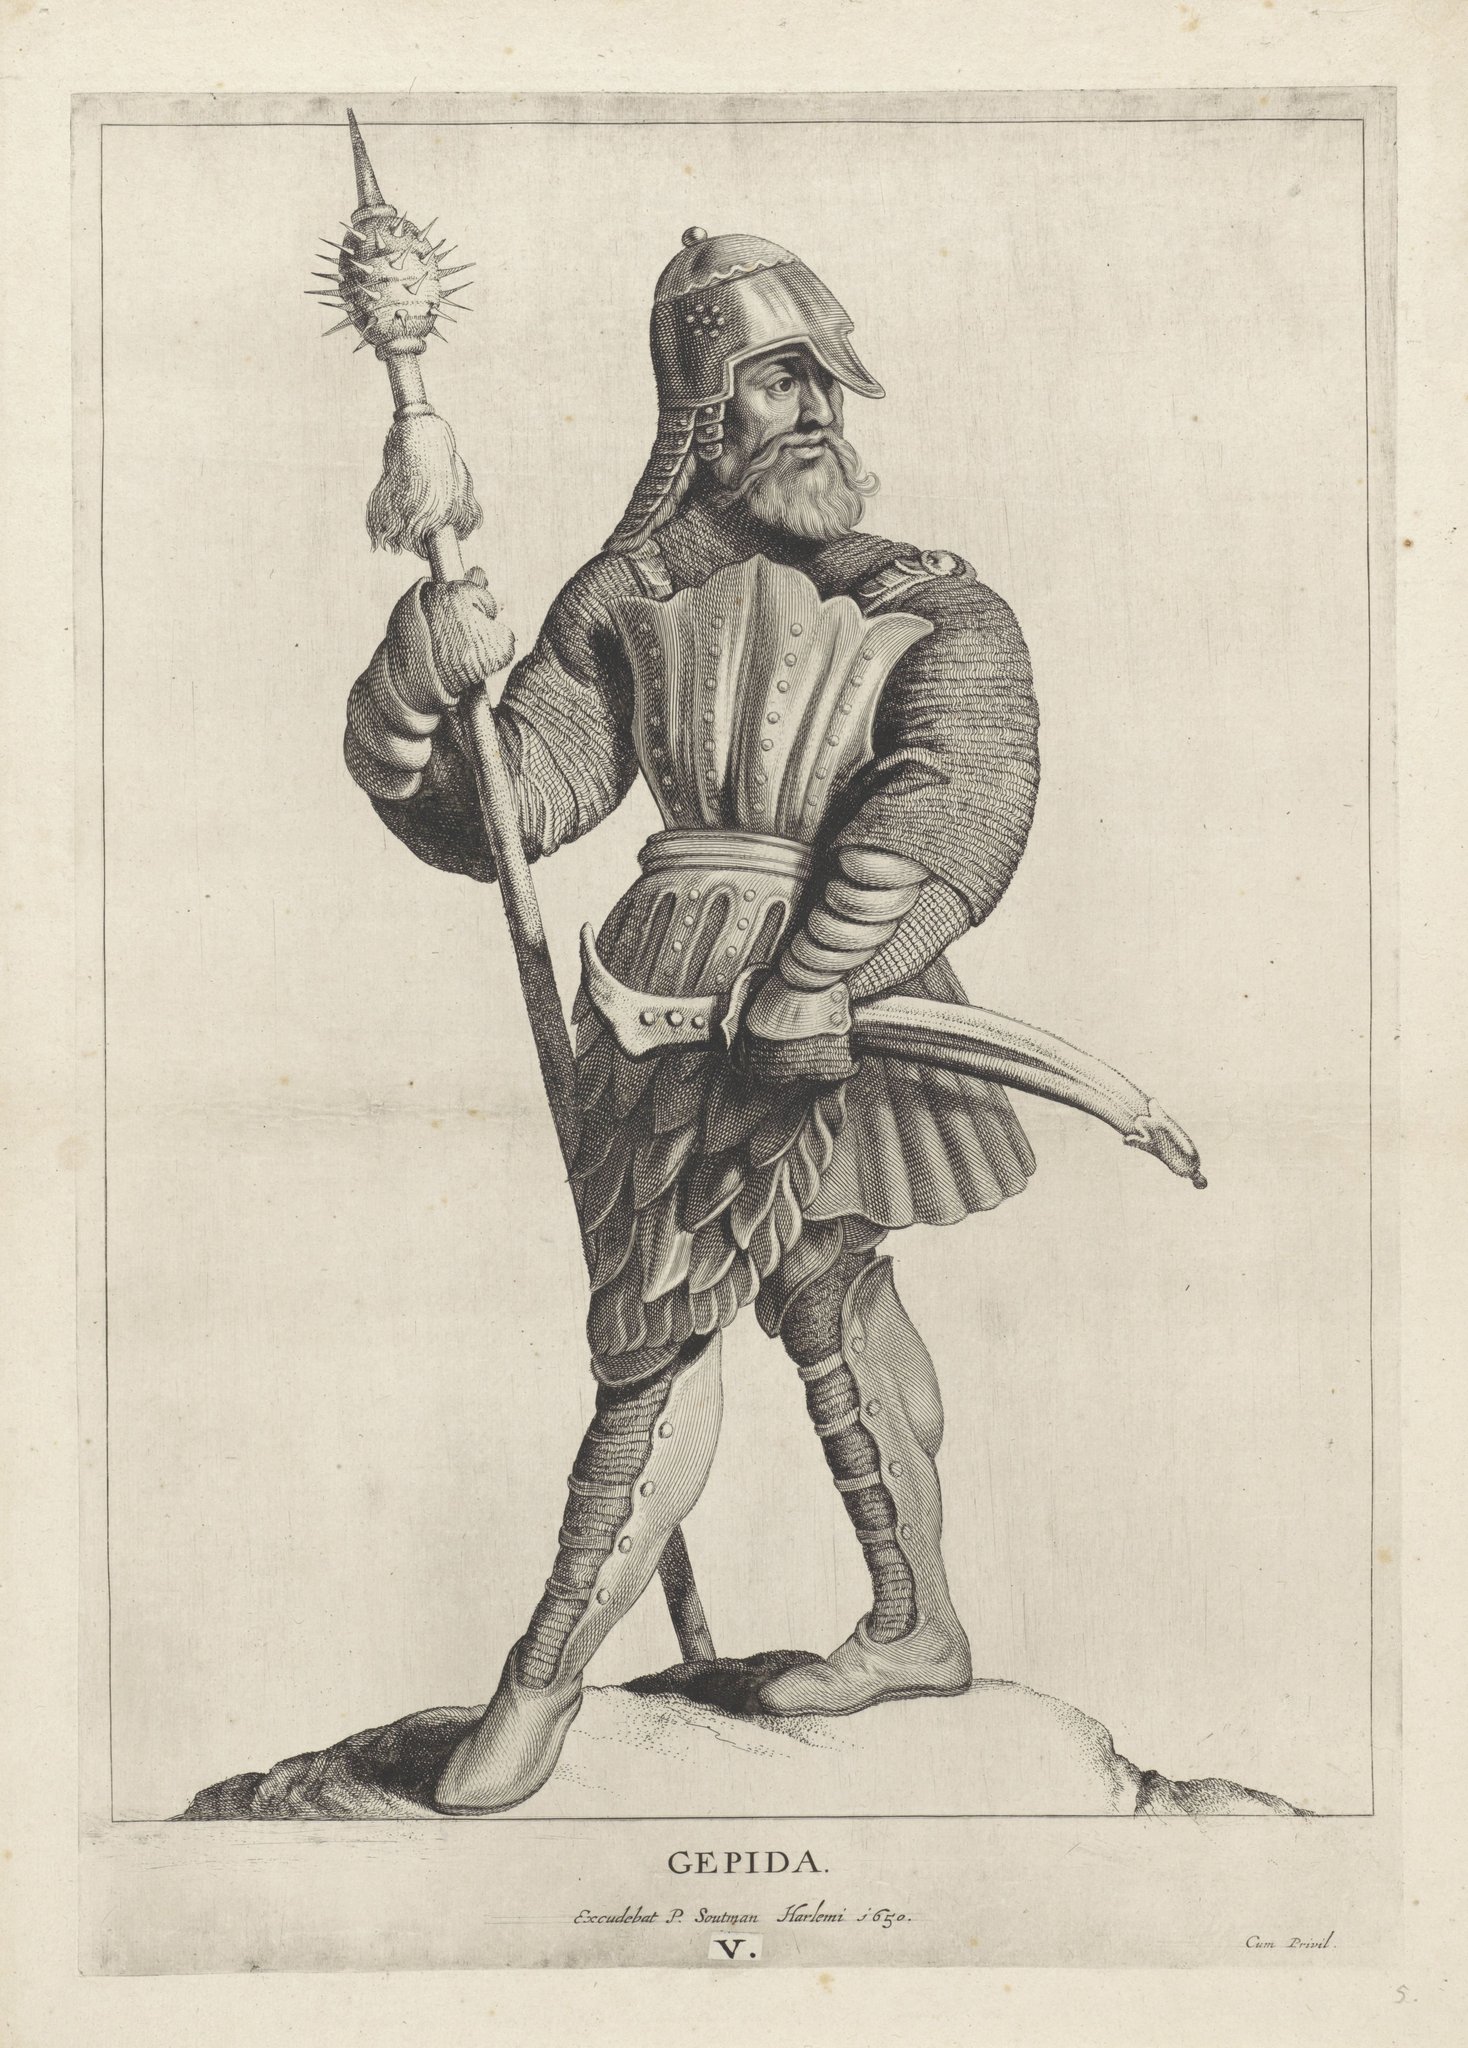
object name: costume print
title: Gepiden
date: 1650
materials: paper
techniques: engraving, etching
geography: haarlem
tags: armour, extinct, 'historical' peoples (with name)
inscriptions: collector's mark: Lugt 240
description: Krijger van het Germaanse volk der Gepiden, staande ten voeten uit, gewapend met een knots en een zwaard.